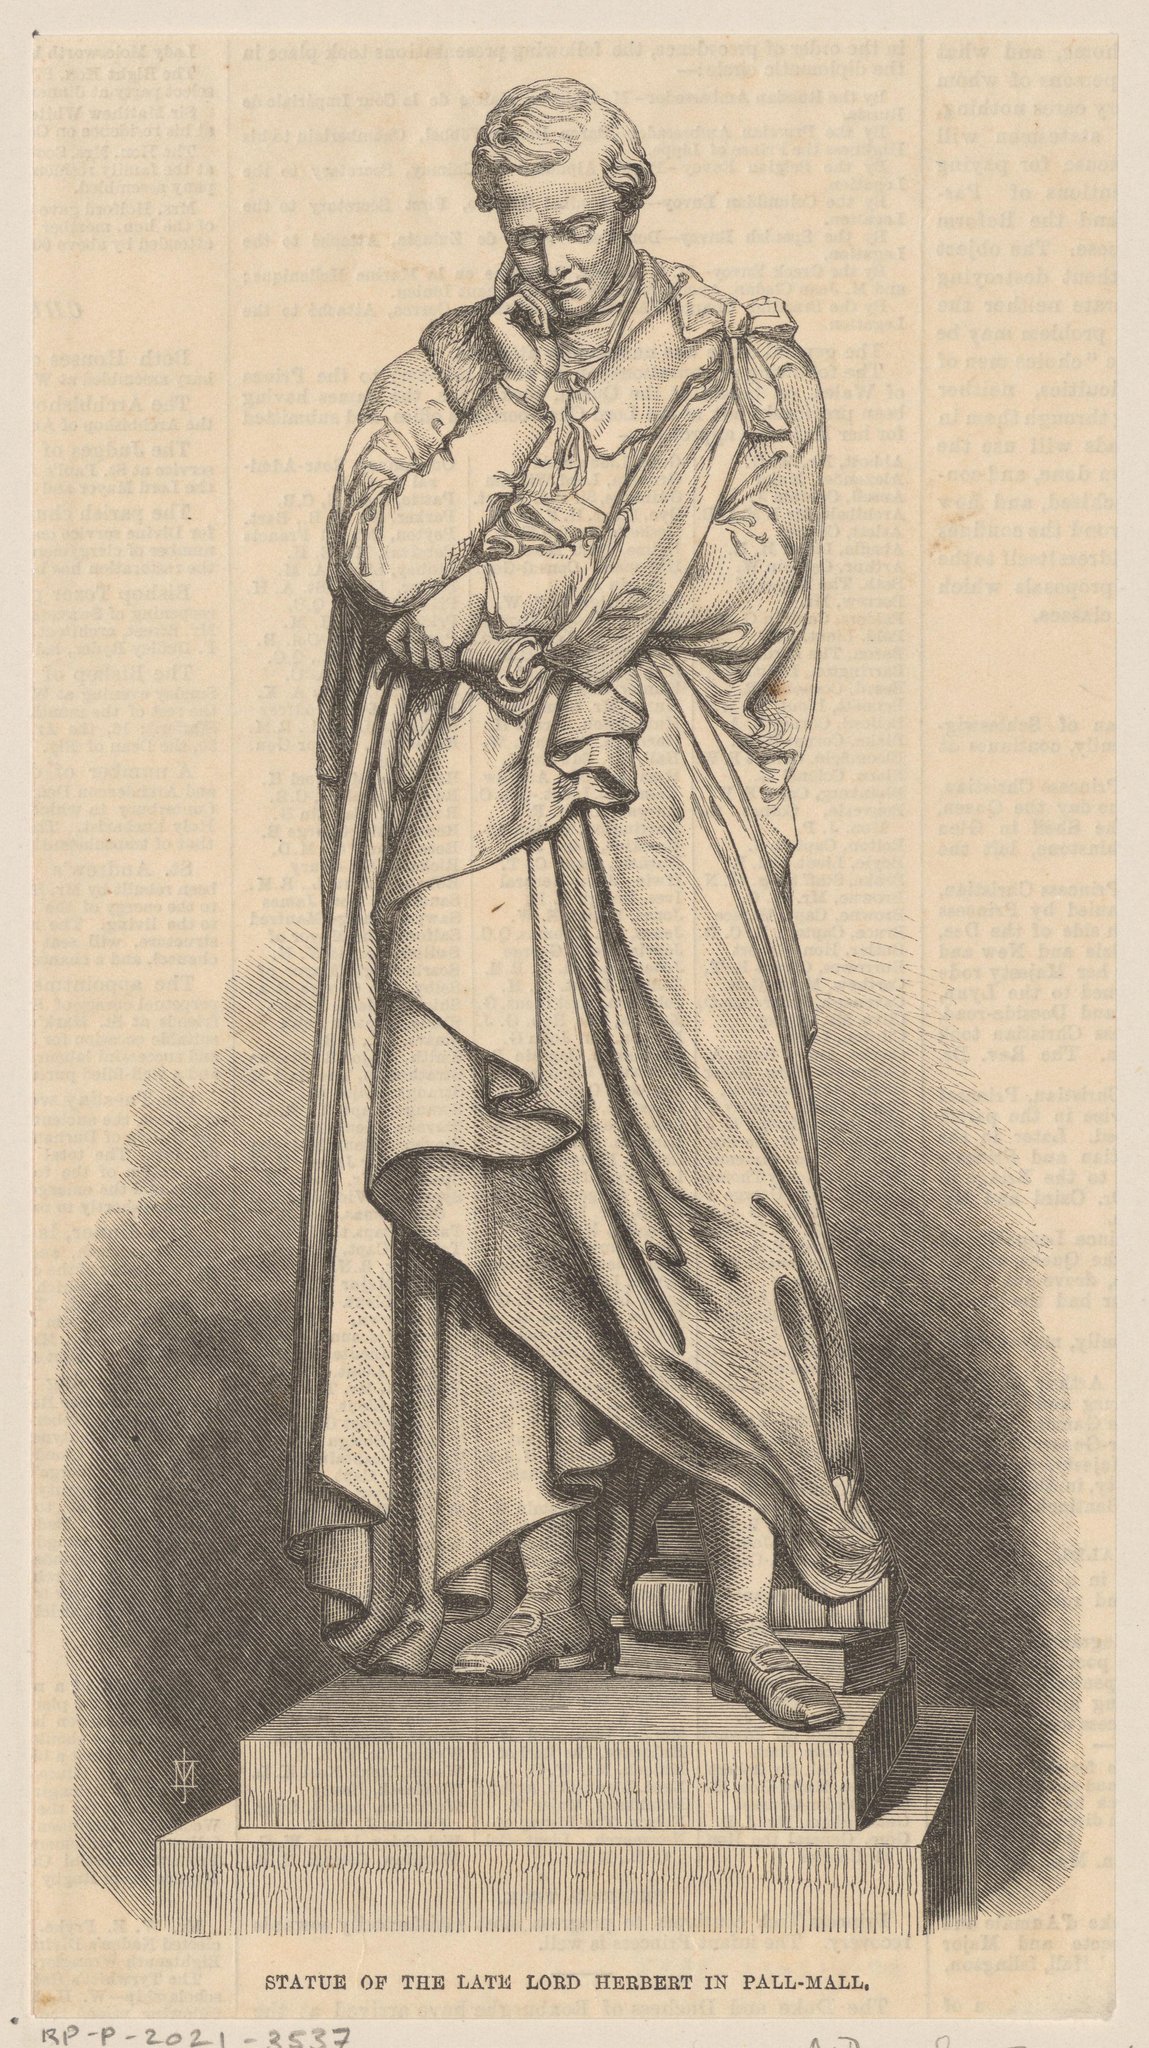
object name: print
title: Standbeeld van Sidney Herbert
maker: Anonymous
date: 1867-1880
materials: paper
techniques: letterpress printing, engraving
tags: historical persons, monument, statue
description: Prent waarschijnlijk uit: The London Illustrated News.